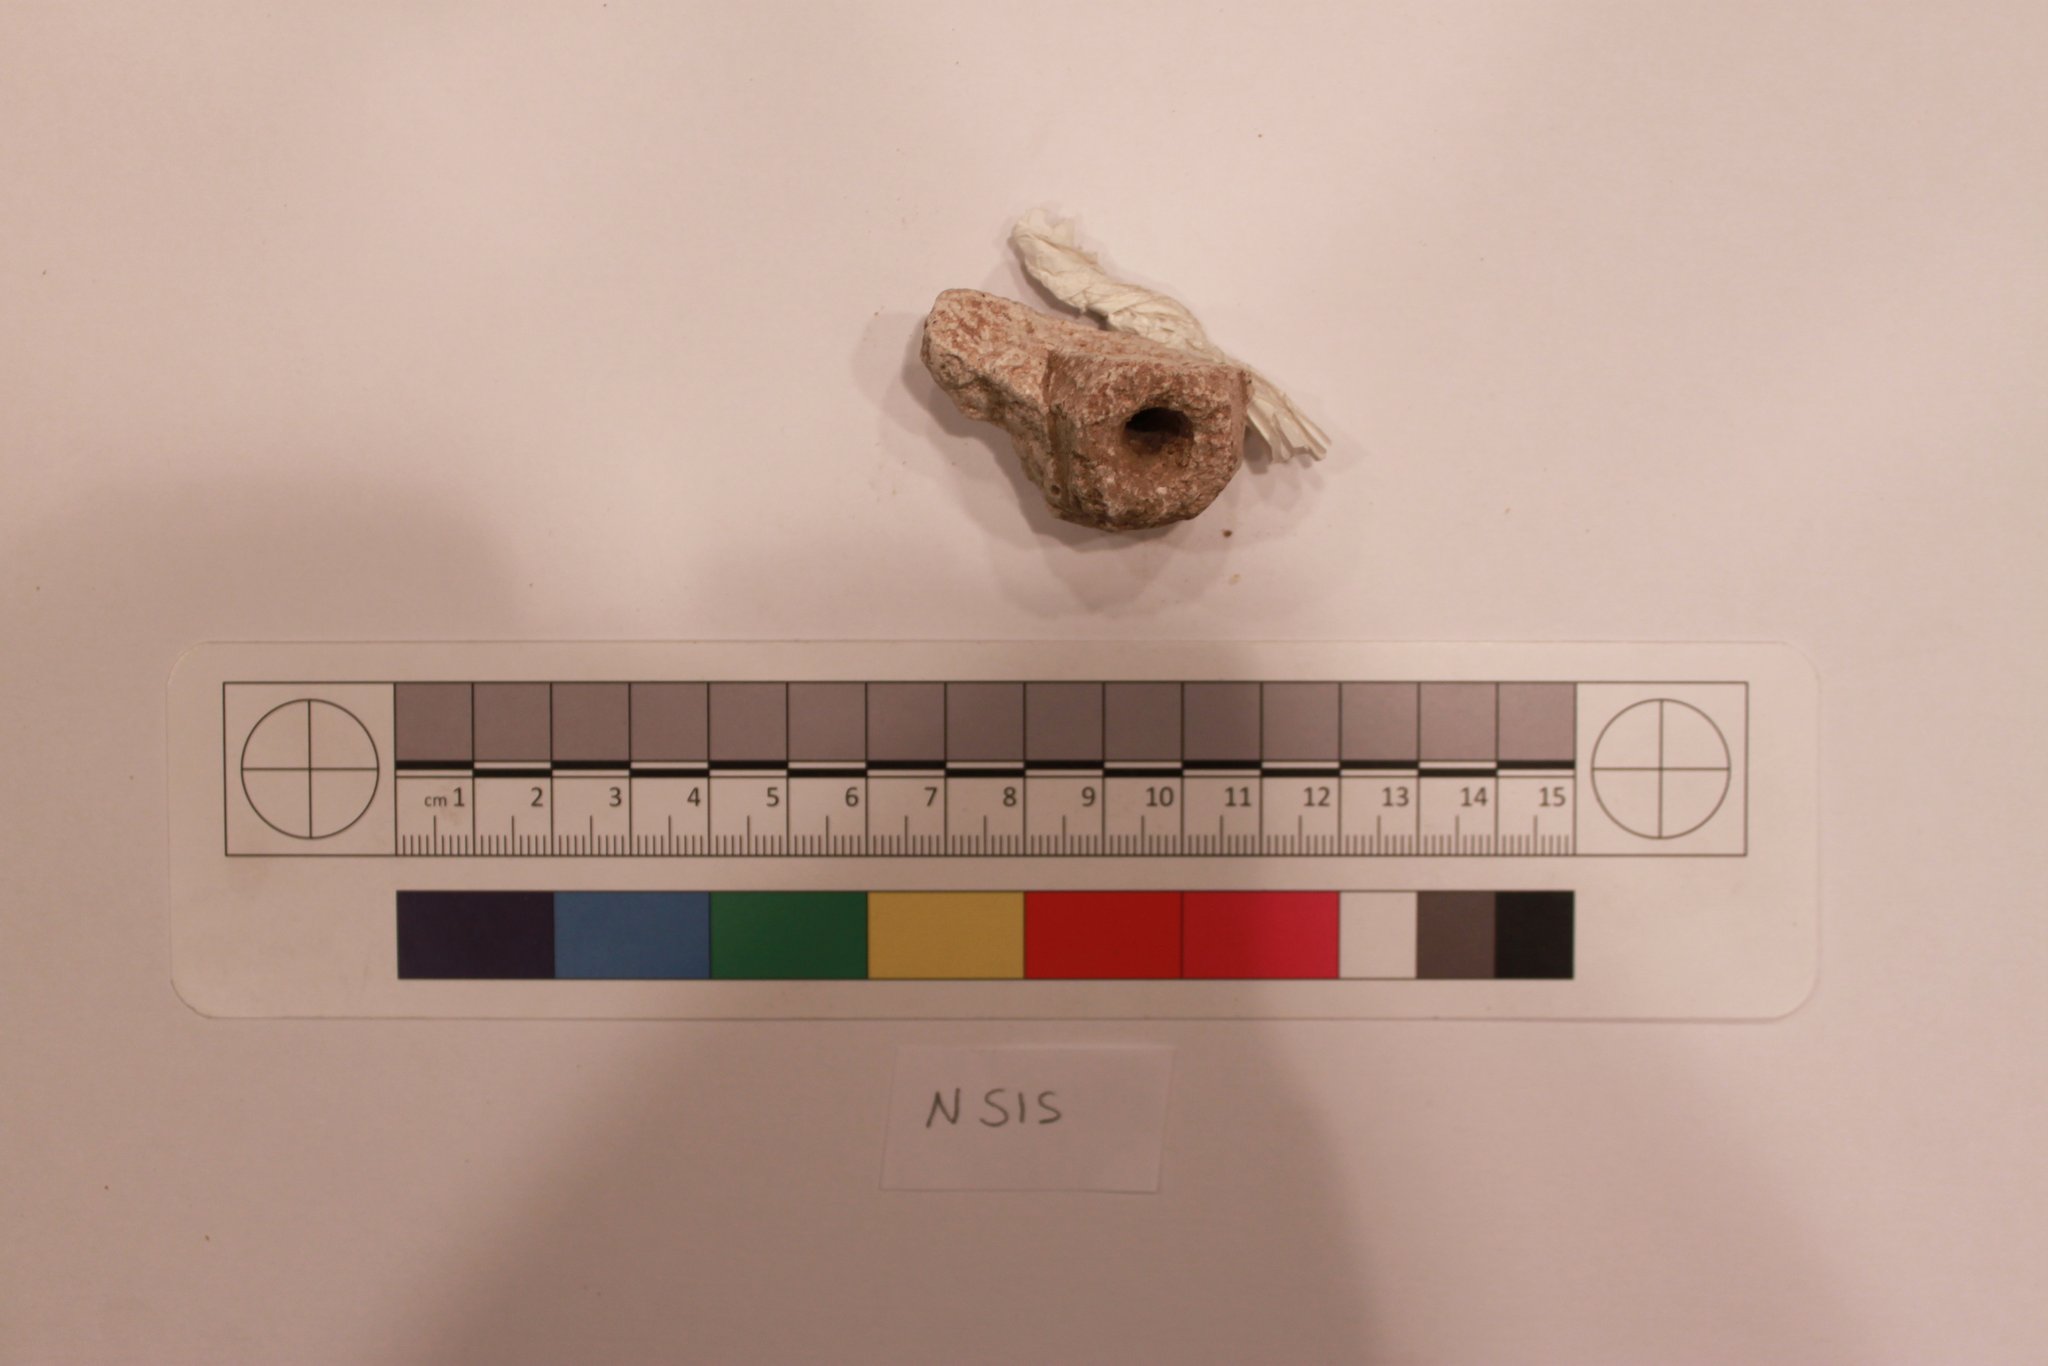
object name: fragment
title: Stucco Fragment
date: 701-1200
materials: plaster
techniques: carving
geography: iran